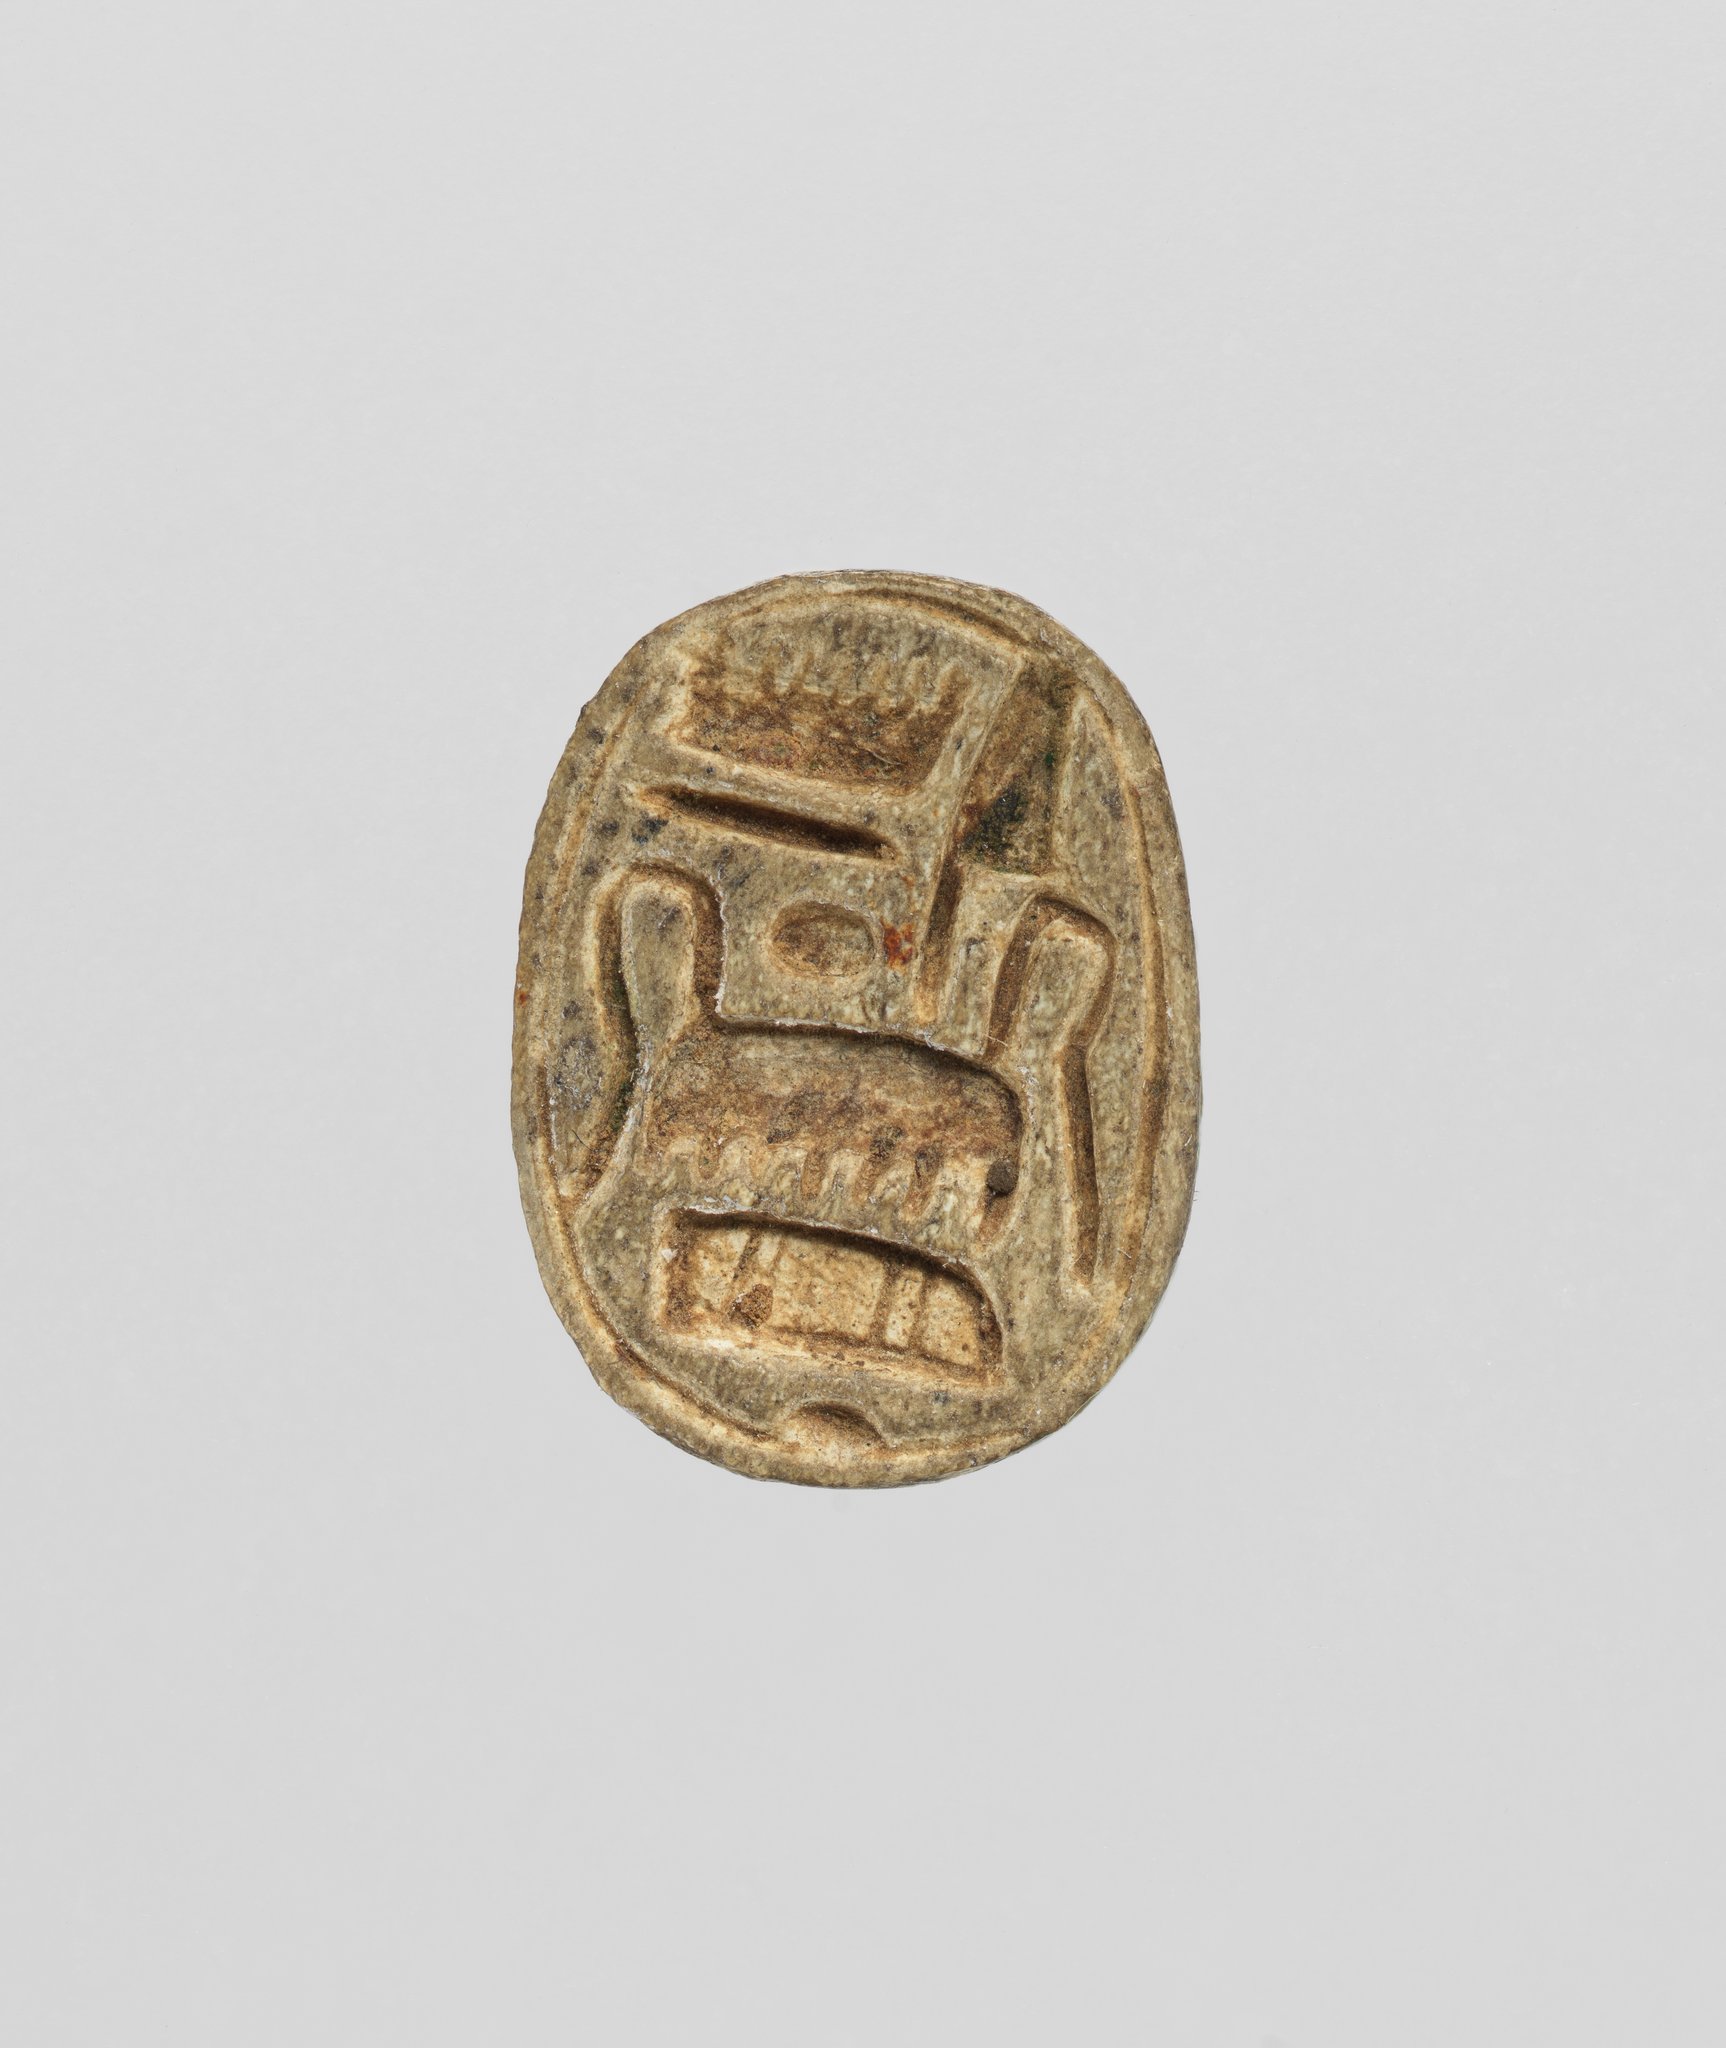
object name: scarab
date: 1295-1070 BCE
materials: stone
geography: egypt